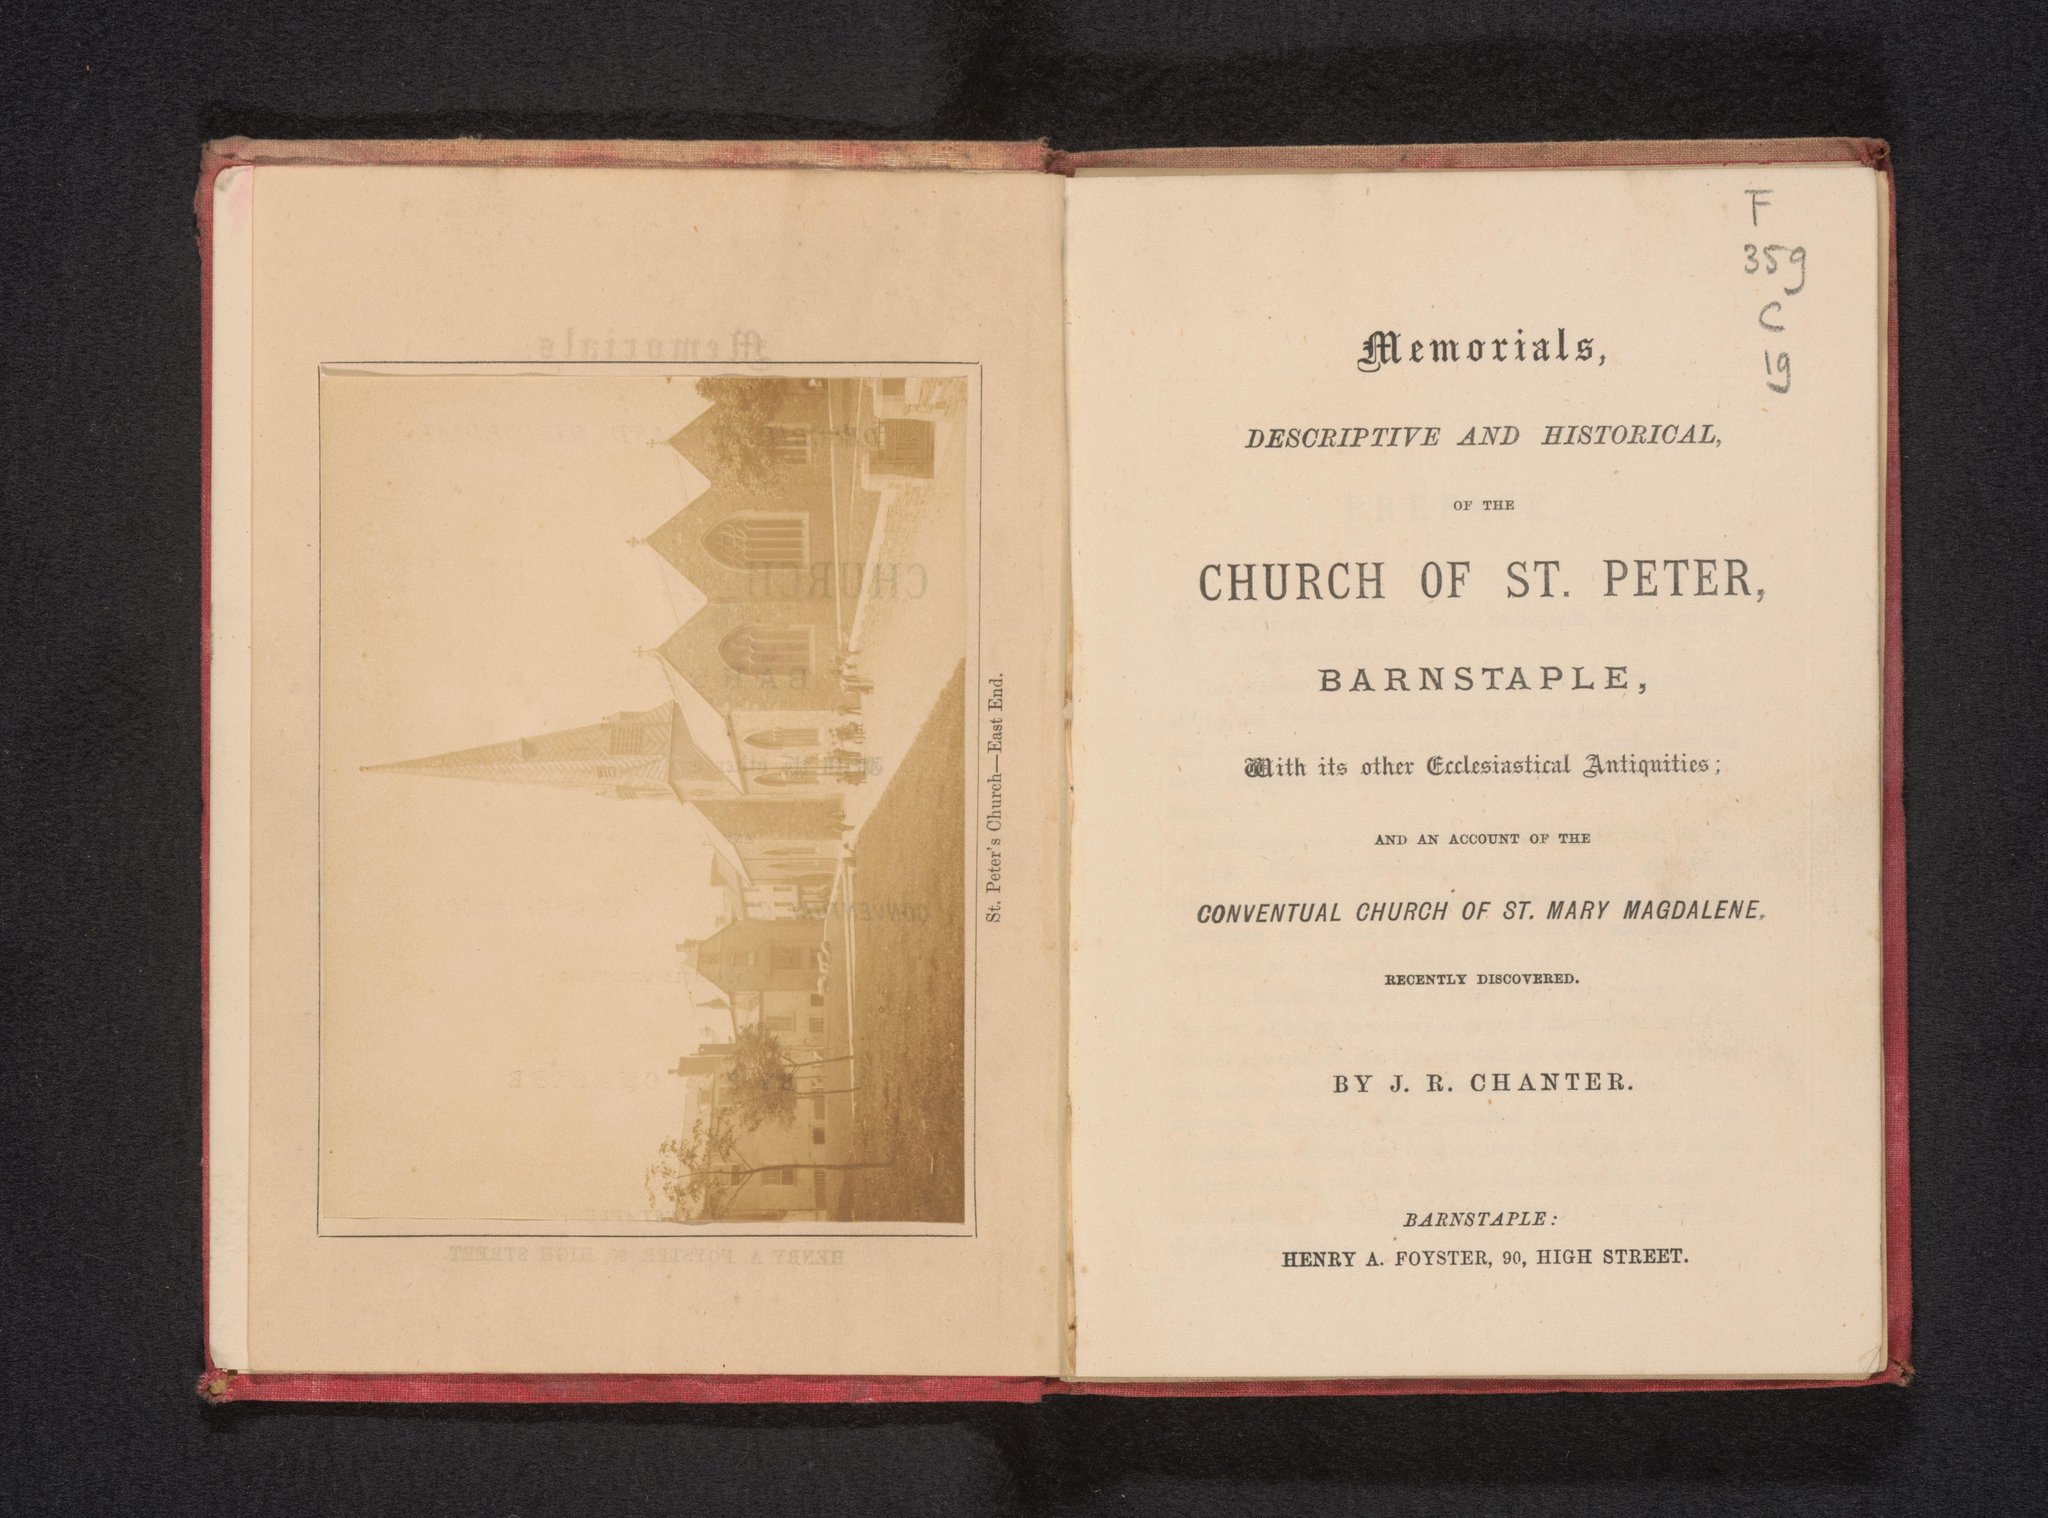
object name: photograph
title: Gezicht op de Sint-Pieterskerk in Barnstaple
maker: Anonymous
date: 1877-1882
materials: photographic support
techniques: albumen print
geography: barnstaple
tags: church (exterior)